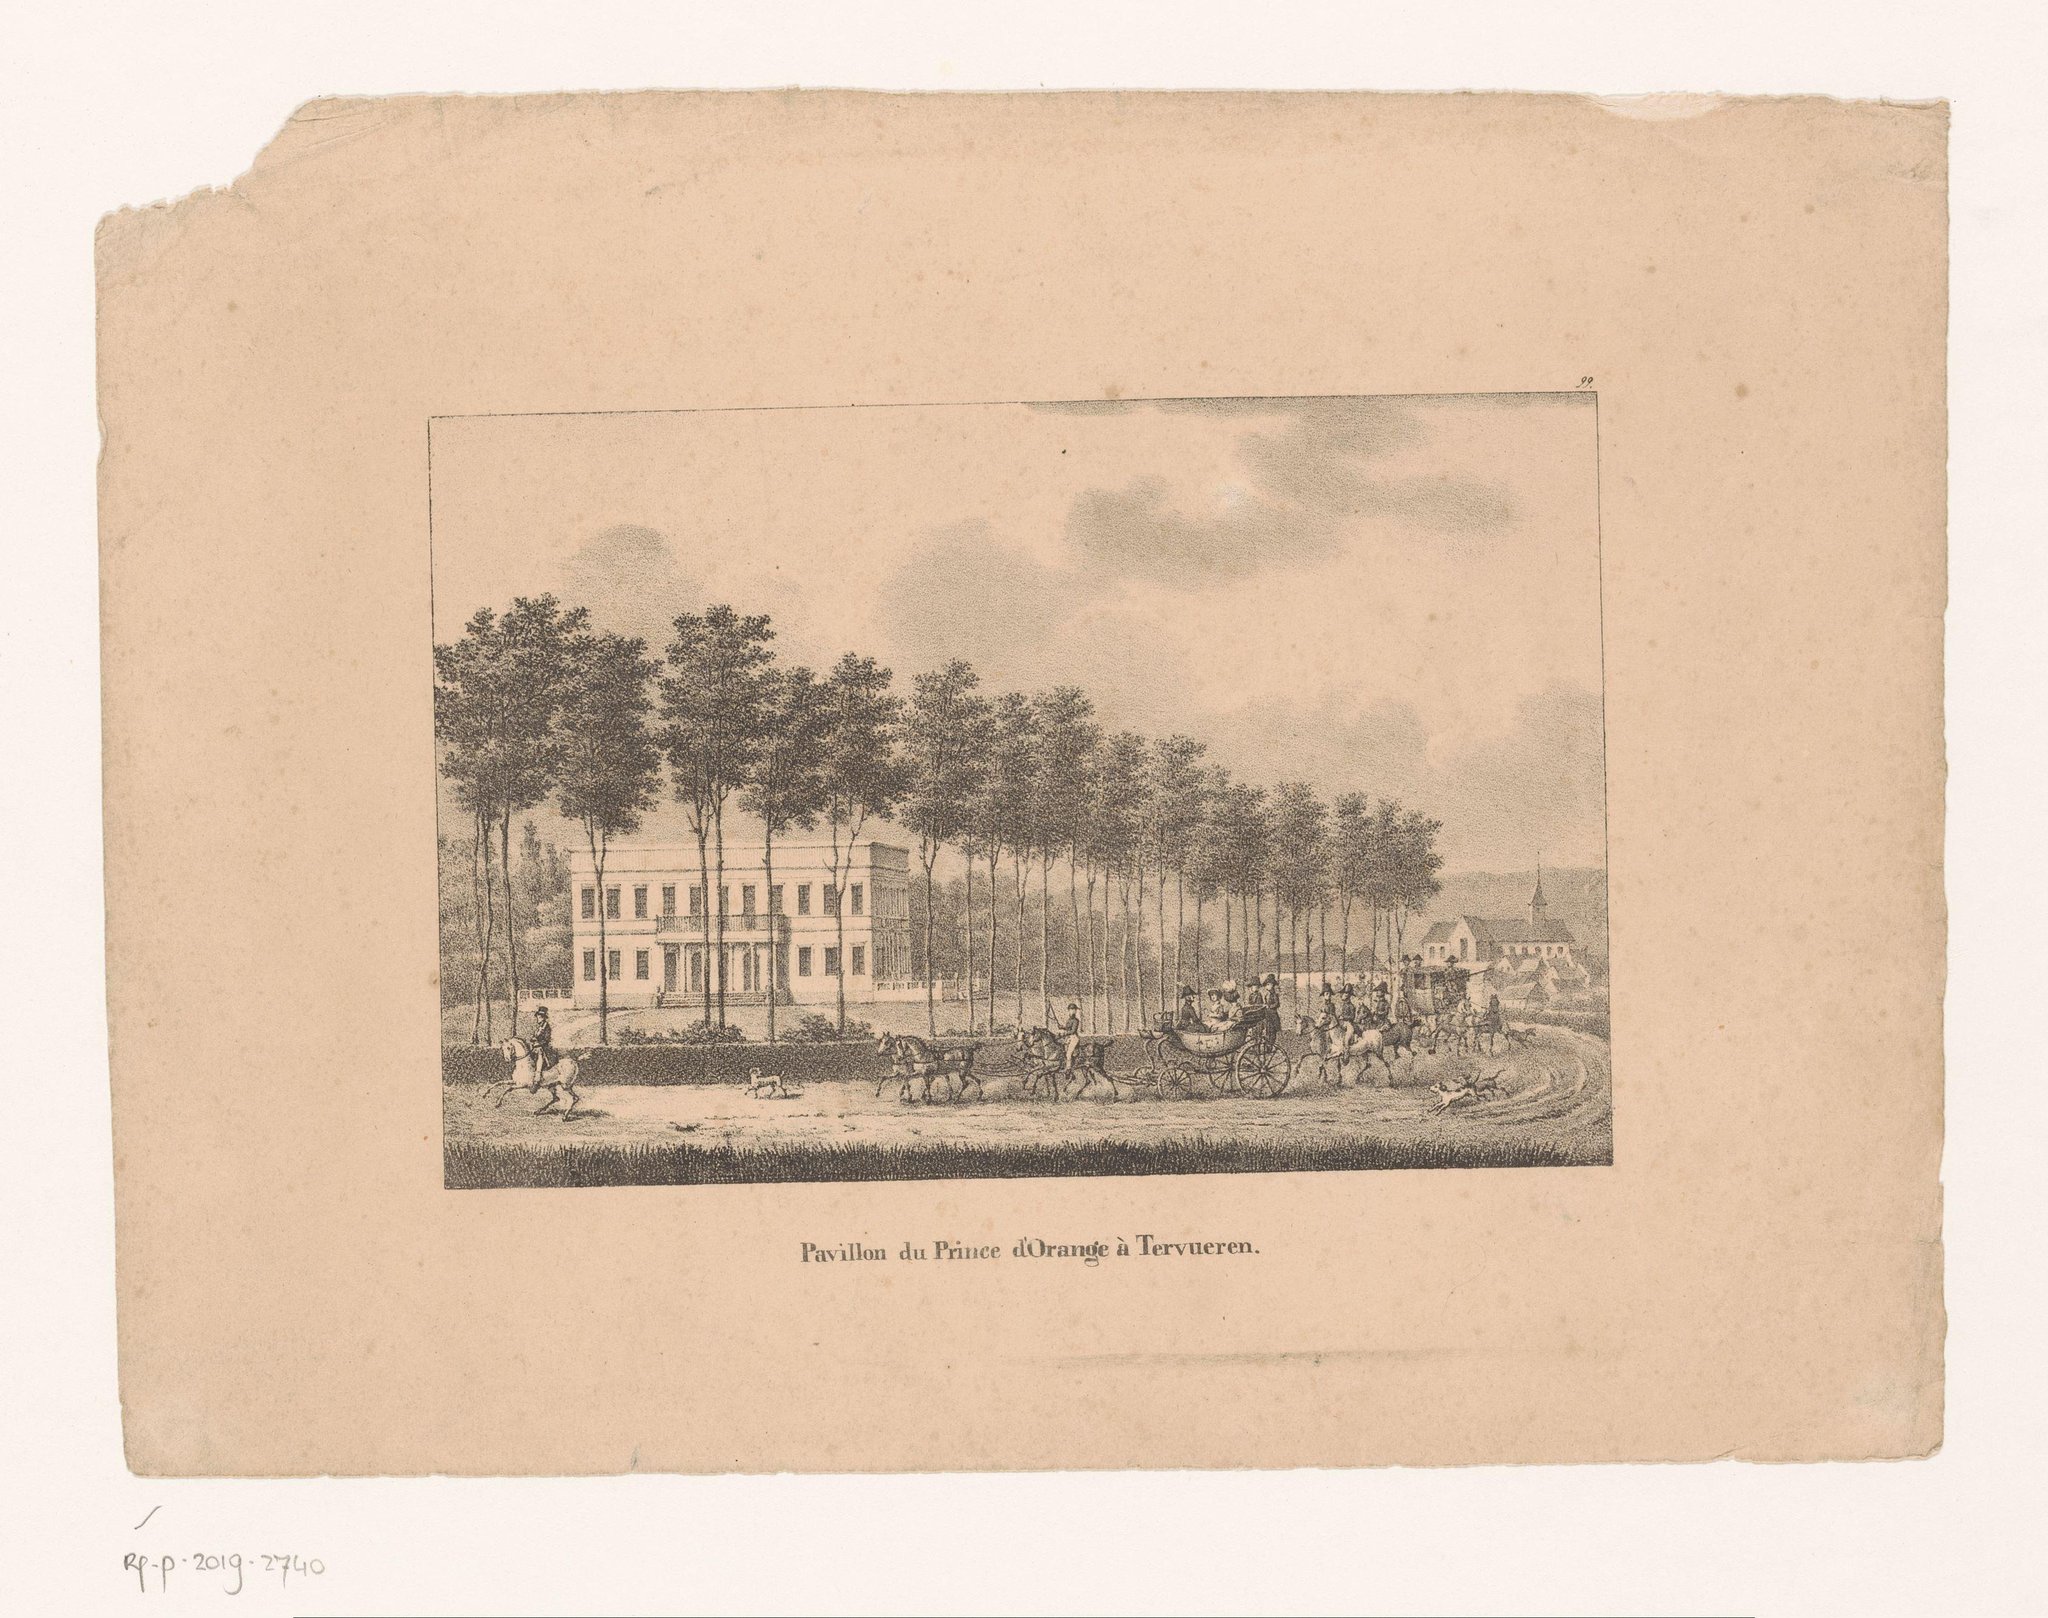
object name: book illustration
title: Pavillon du prince d'Orange à Tervueren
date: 1815-1830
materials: paper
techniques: lithograph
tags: four-wheeled, animal-drawn vehicle, e.g.: cab, carriage, coach, palace